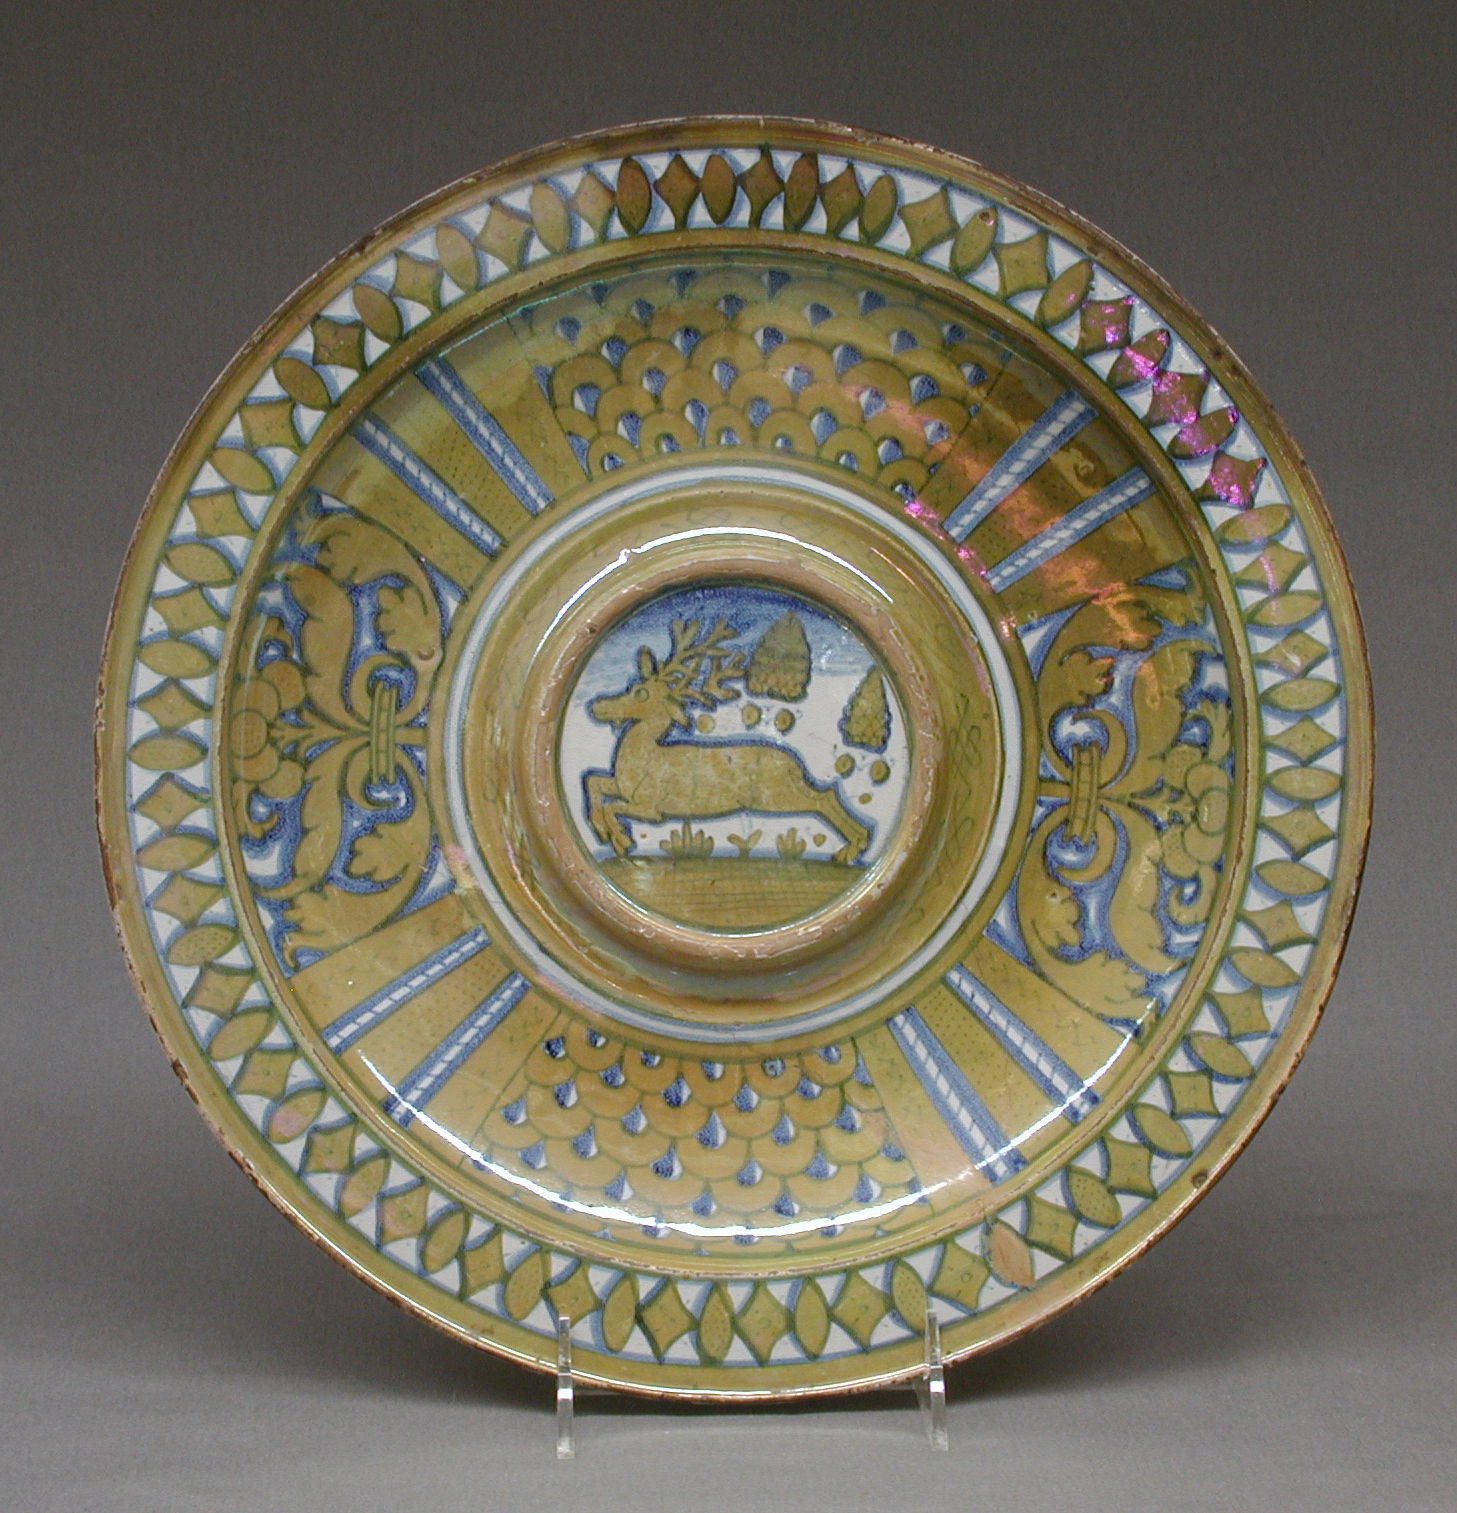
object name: dish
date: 1510-1520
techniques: maiolica, glazing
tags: deer